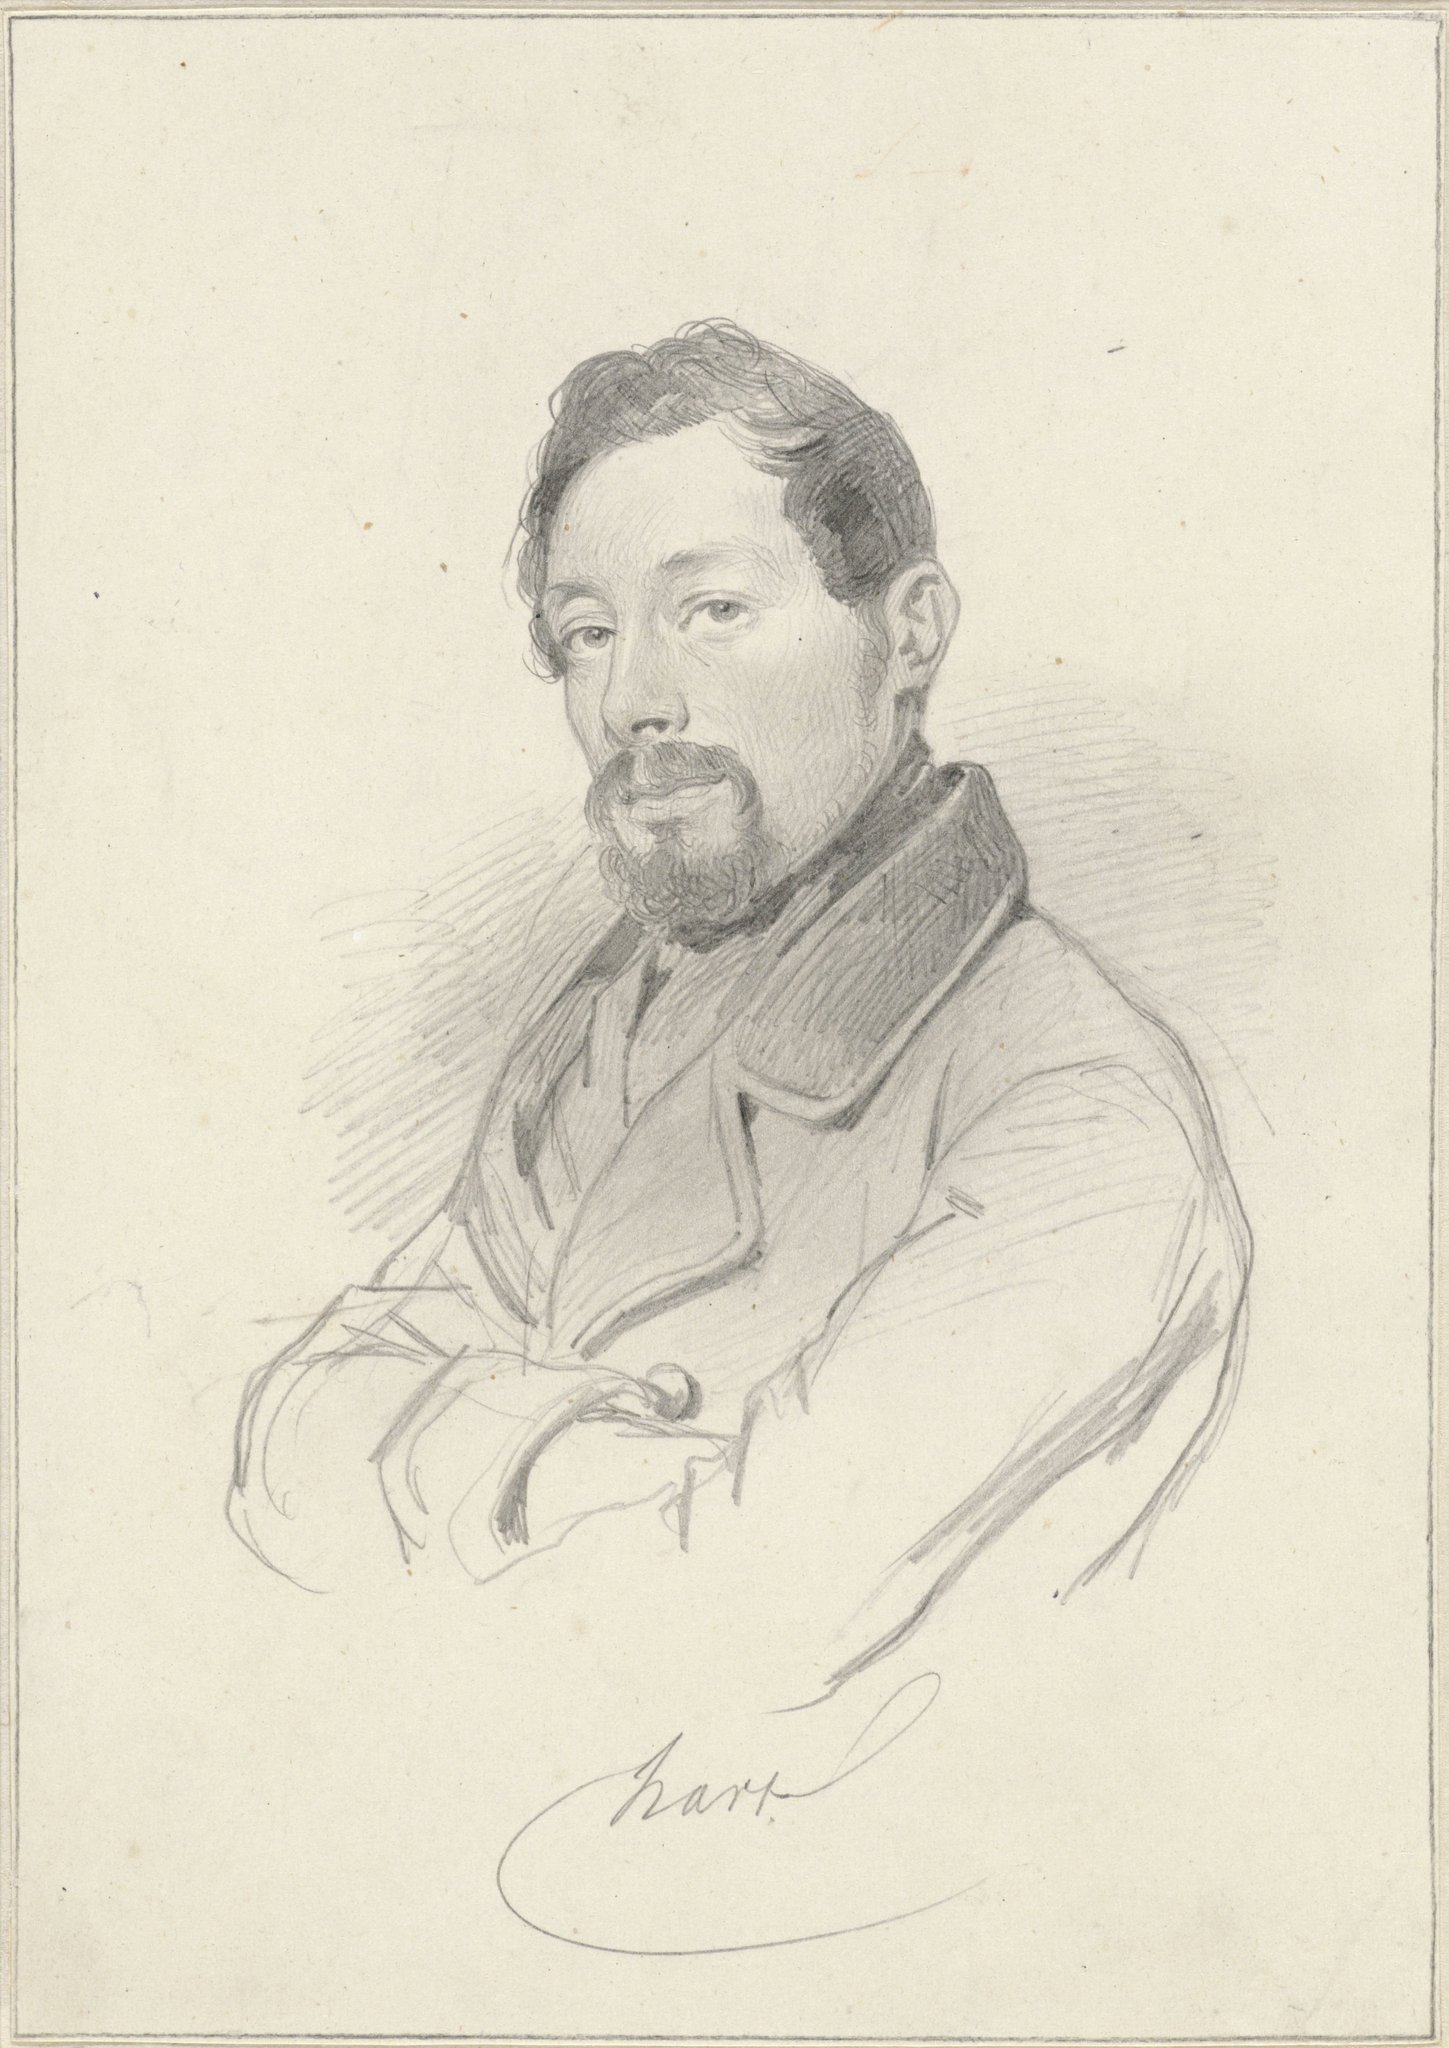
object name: drawing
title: Portret van Laurent Joseph Hart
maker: Anonymous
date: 1840-1842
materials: paper, pencil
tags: antwerp, brussels, die cutter, laurent joseph hart, historical persons, portrait, self-portrait of painter, portrait, self-portrait of artist, portrait, self-portrait of draughtsman